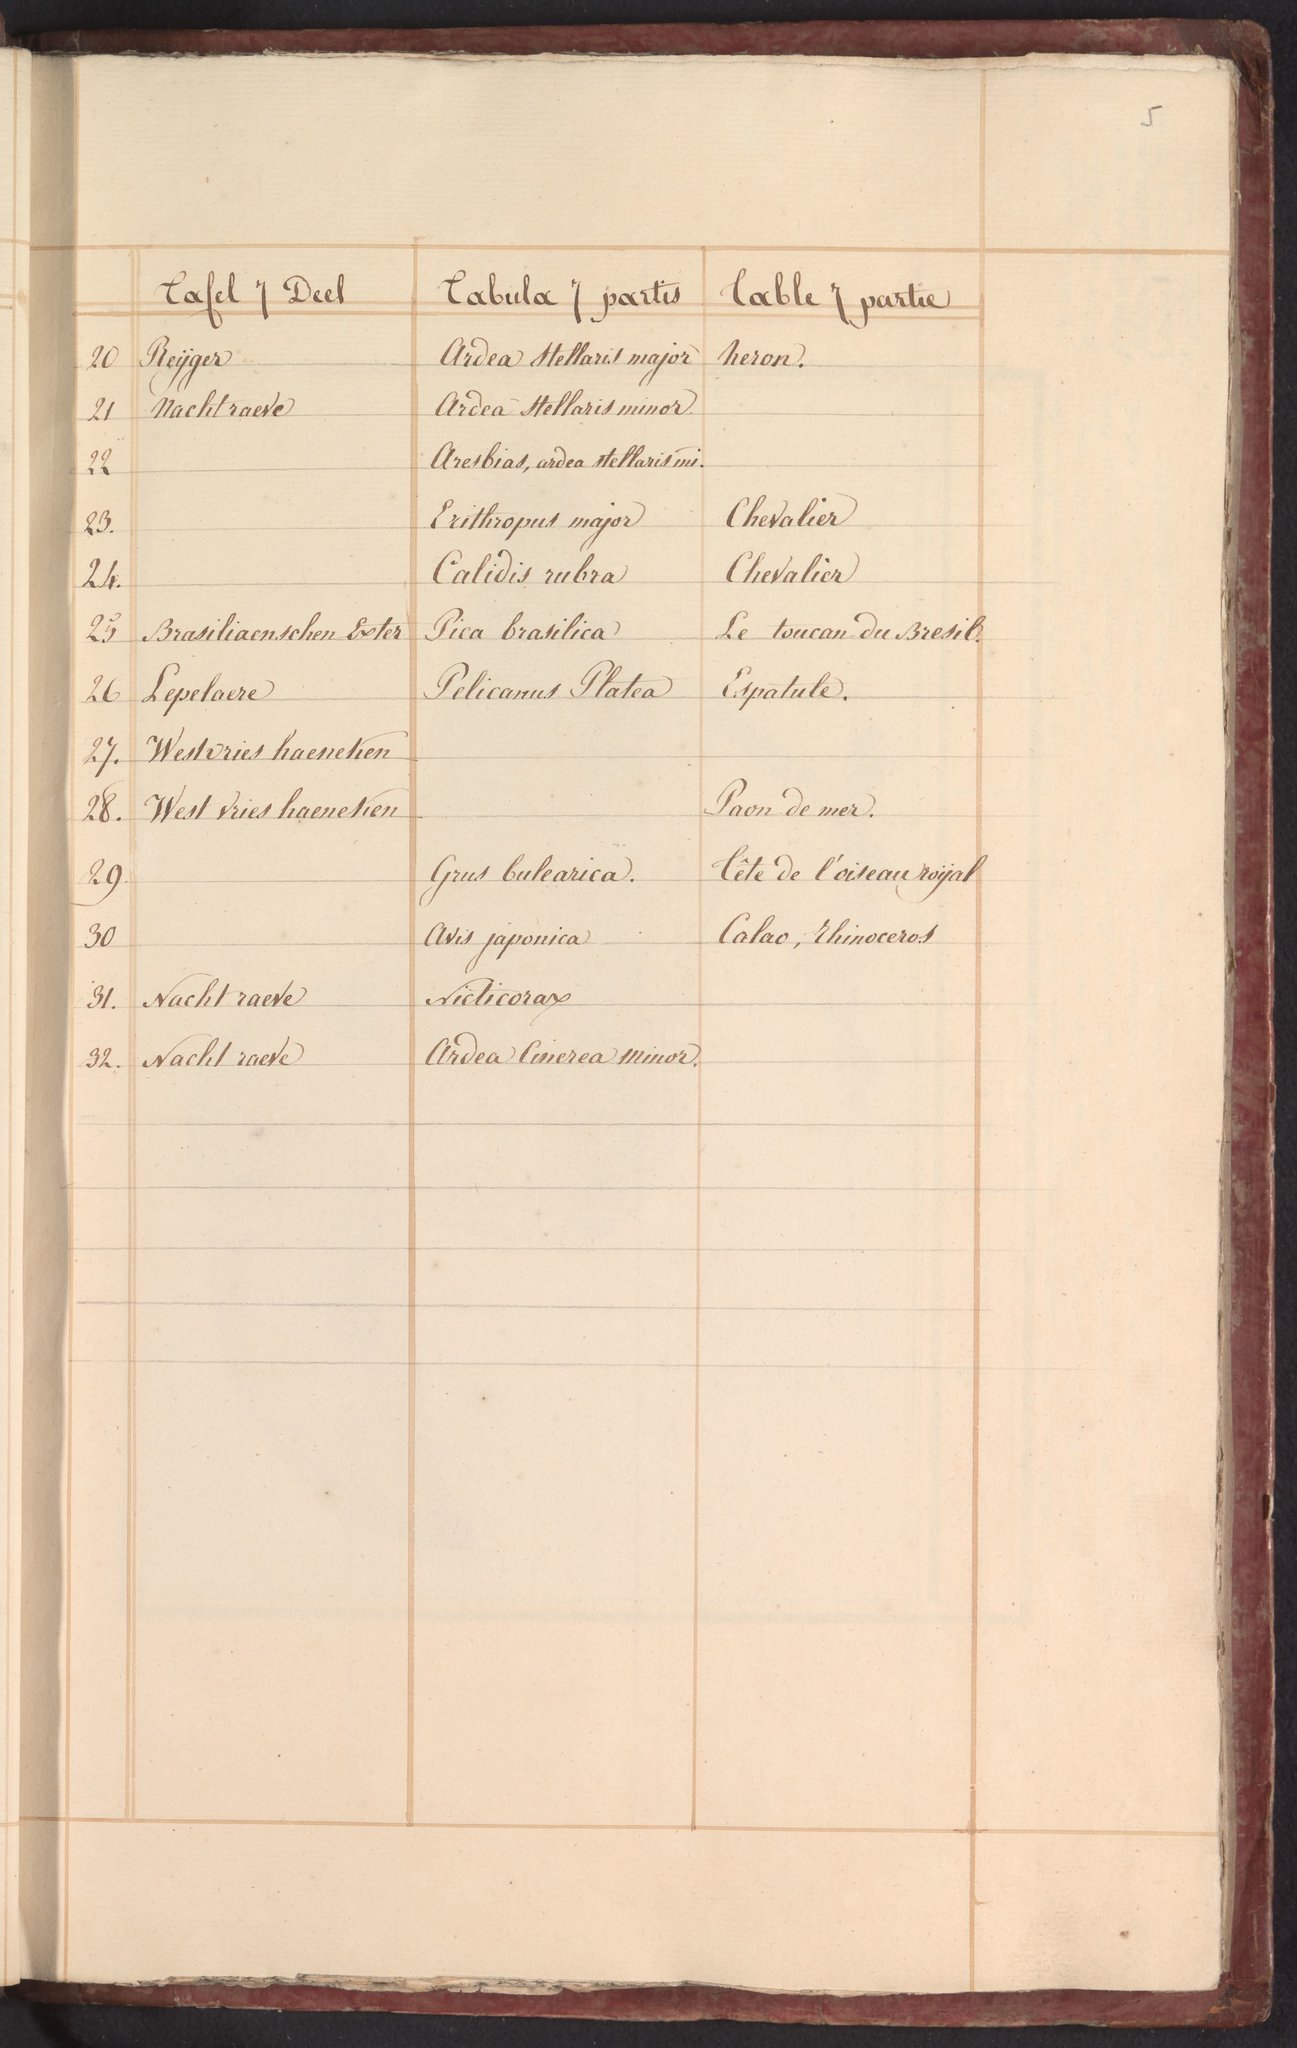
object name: manuscript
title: Lijst van vogels in het zevende deel van de vogels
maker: joseph van huerne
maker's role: kunstliefhebber, mecenas, verzamelaar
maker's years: 1752-1844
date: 1809-1814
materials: ink, paper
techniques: handwriting, pen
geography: bruges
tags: handwriting, written text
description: Schema met een lijst van vogels voorgesteld in het zevende deel van de vogels: nummers 20-32. Onderdeel van het derde album met tekeningen van vogels. Vijfde van twaalf albums met tekeningen van dieren, vogels en planten bekend rond 1600, gemaakt in opdracht van keizer Rudolf II. Met toelichting in Nederlands, Latijn en Frans.